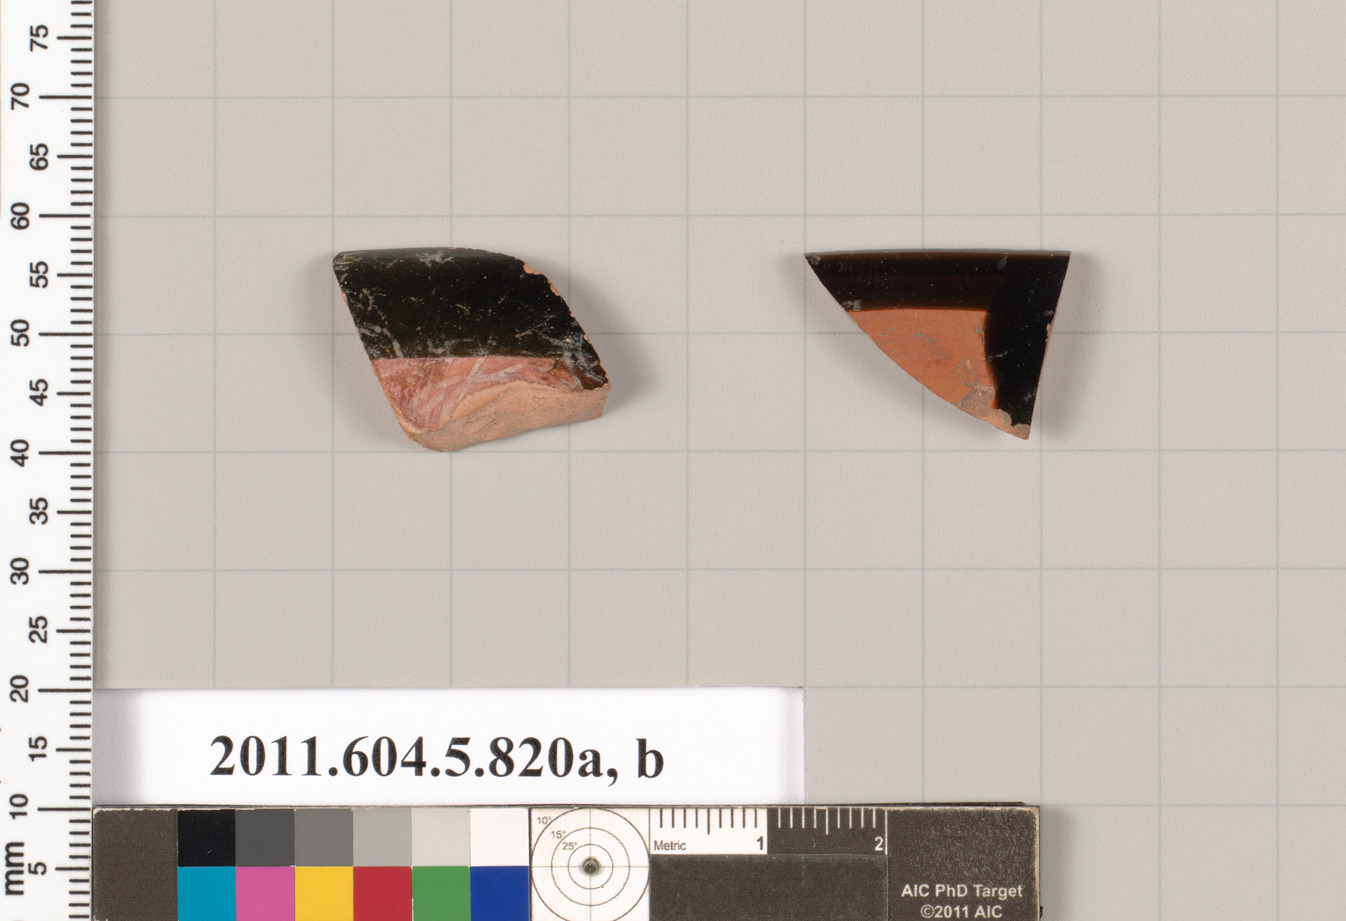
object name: kylix fragment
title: Terracotta rim fragments of kylikes (drinking cups)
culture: greek, attic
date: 600-401 BCE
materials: terracotta